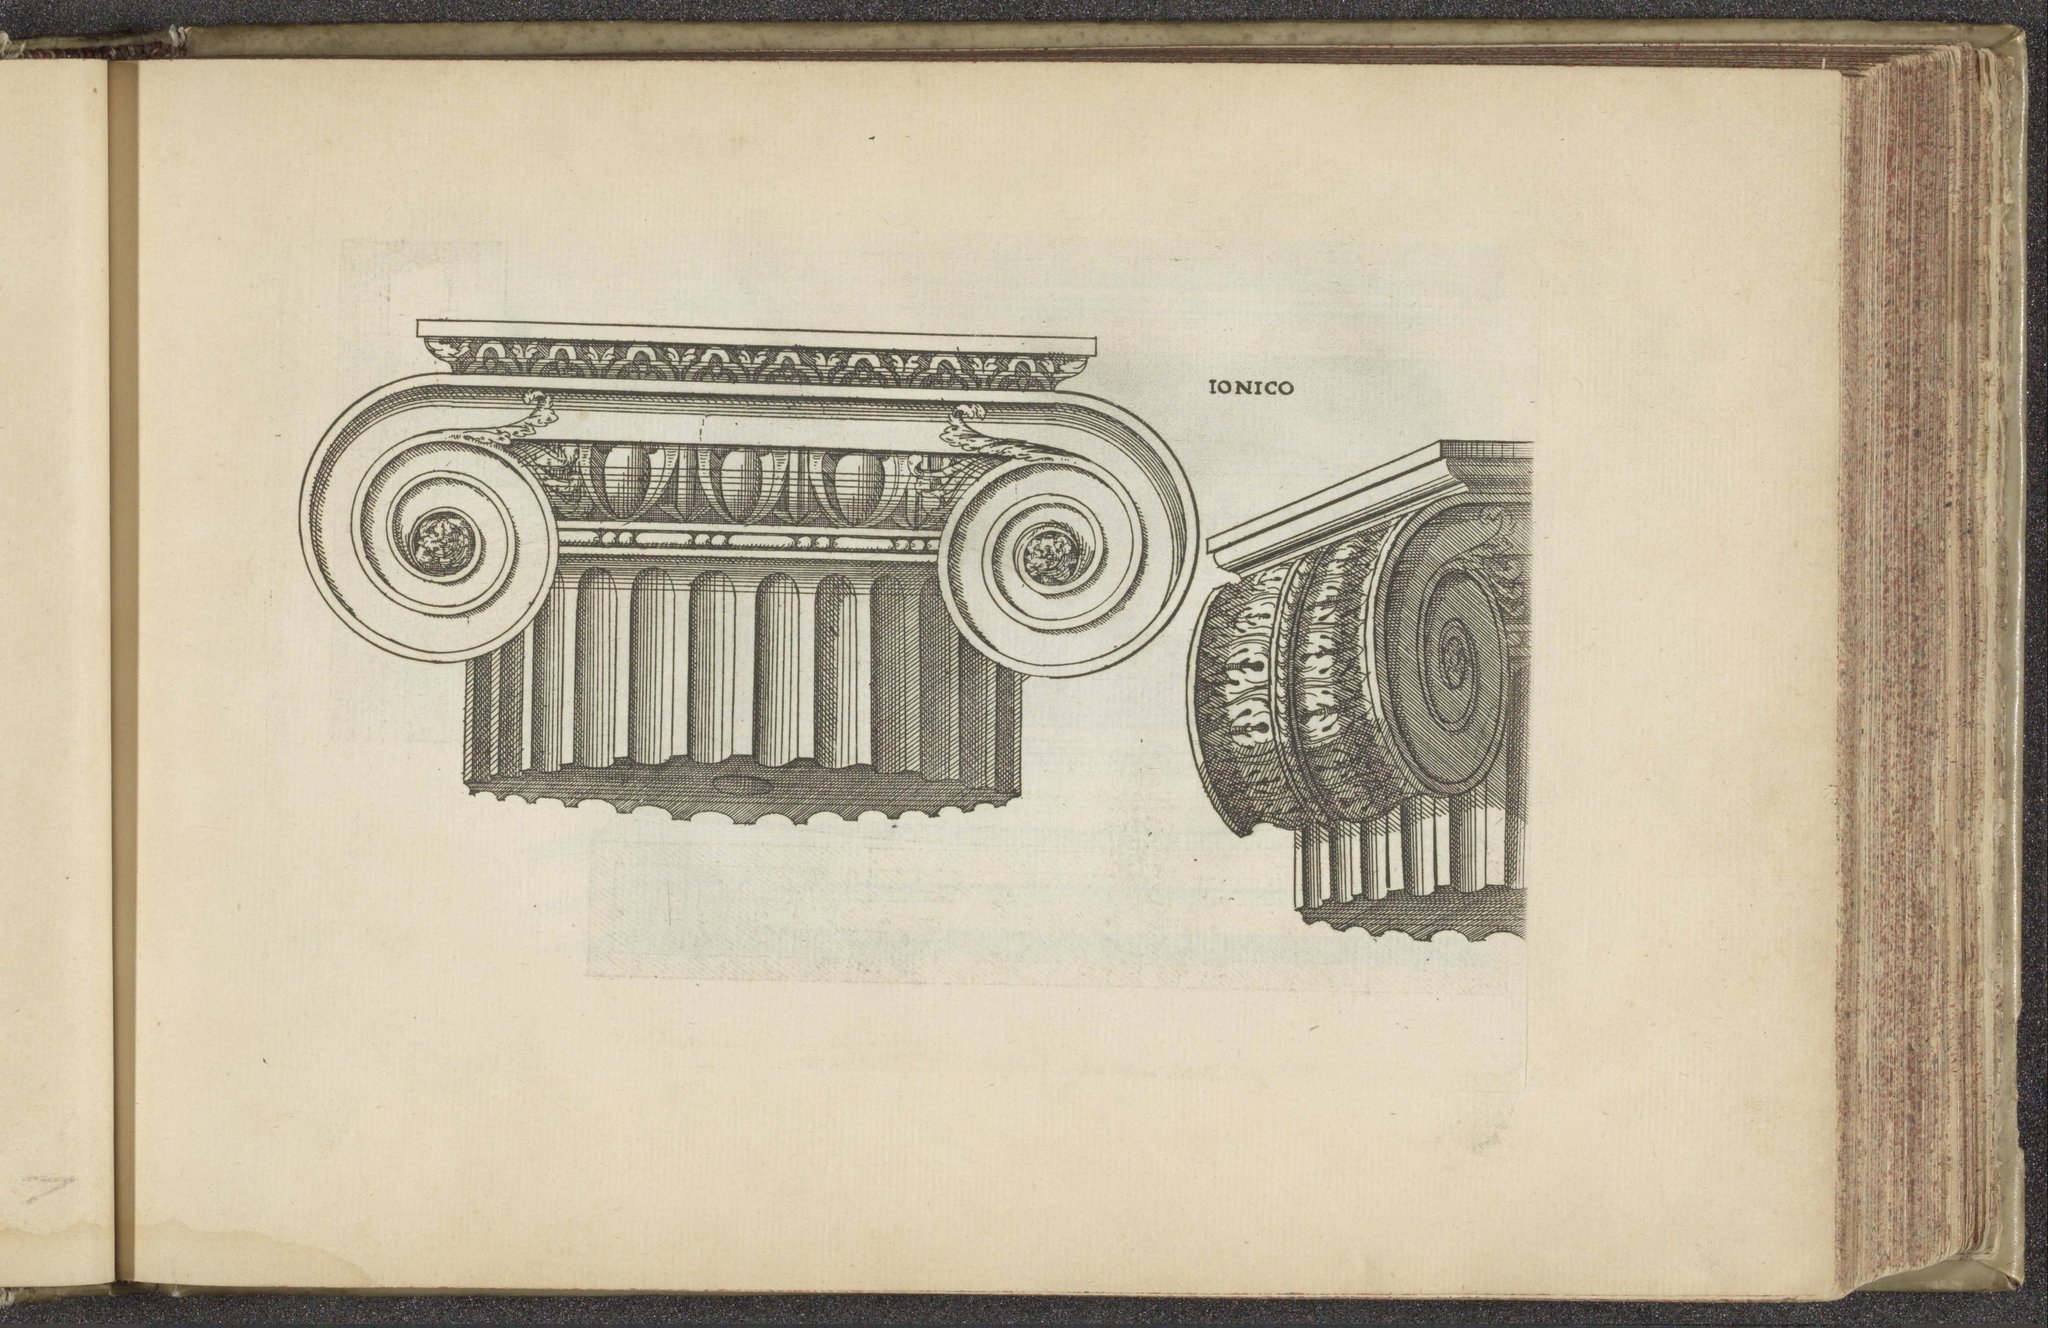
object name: album leaf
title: Kapiteel van de Ionische orde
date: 1601-1651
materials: paper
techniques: etching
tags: ionic order ~ architecture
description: Kapiteel van de Ionische orde. Deze prent maakt deel uit van een album.